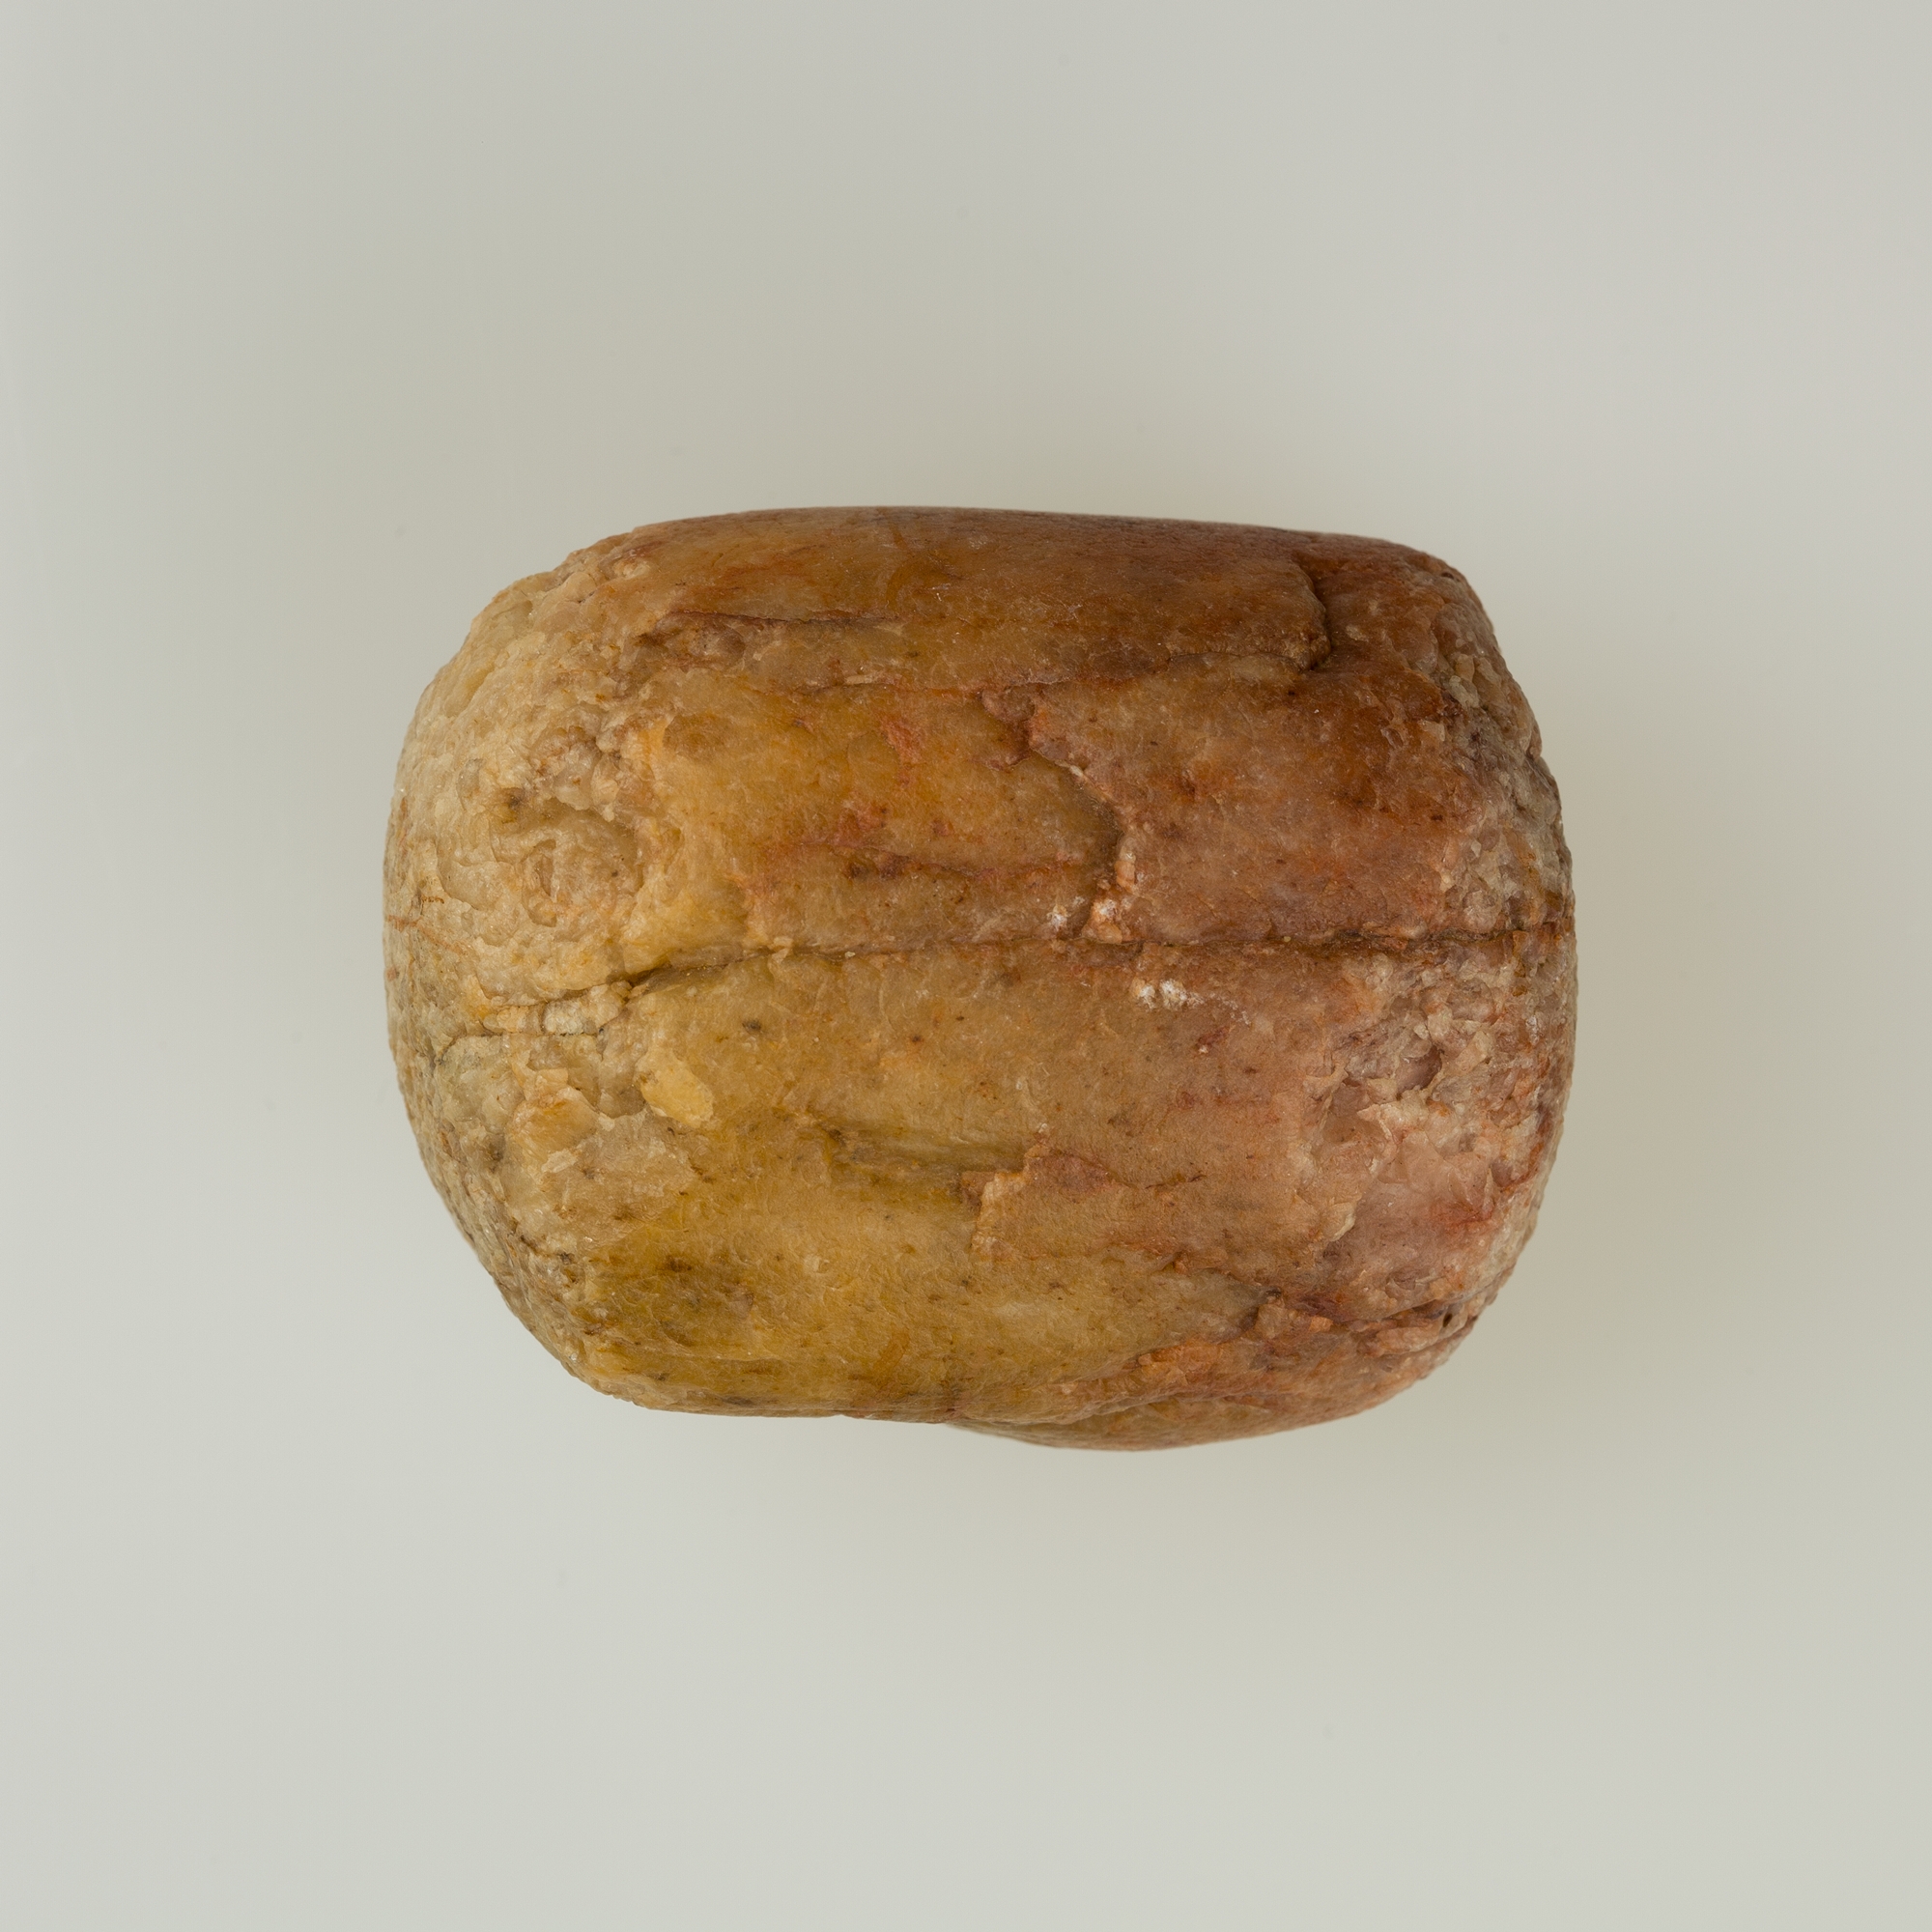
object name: pestle, pounder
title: Pounder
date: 4500-4000 BCE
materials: quartz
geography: egypt